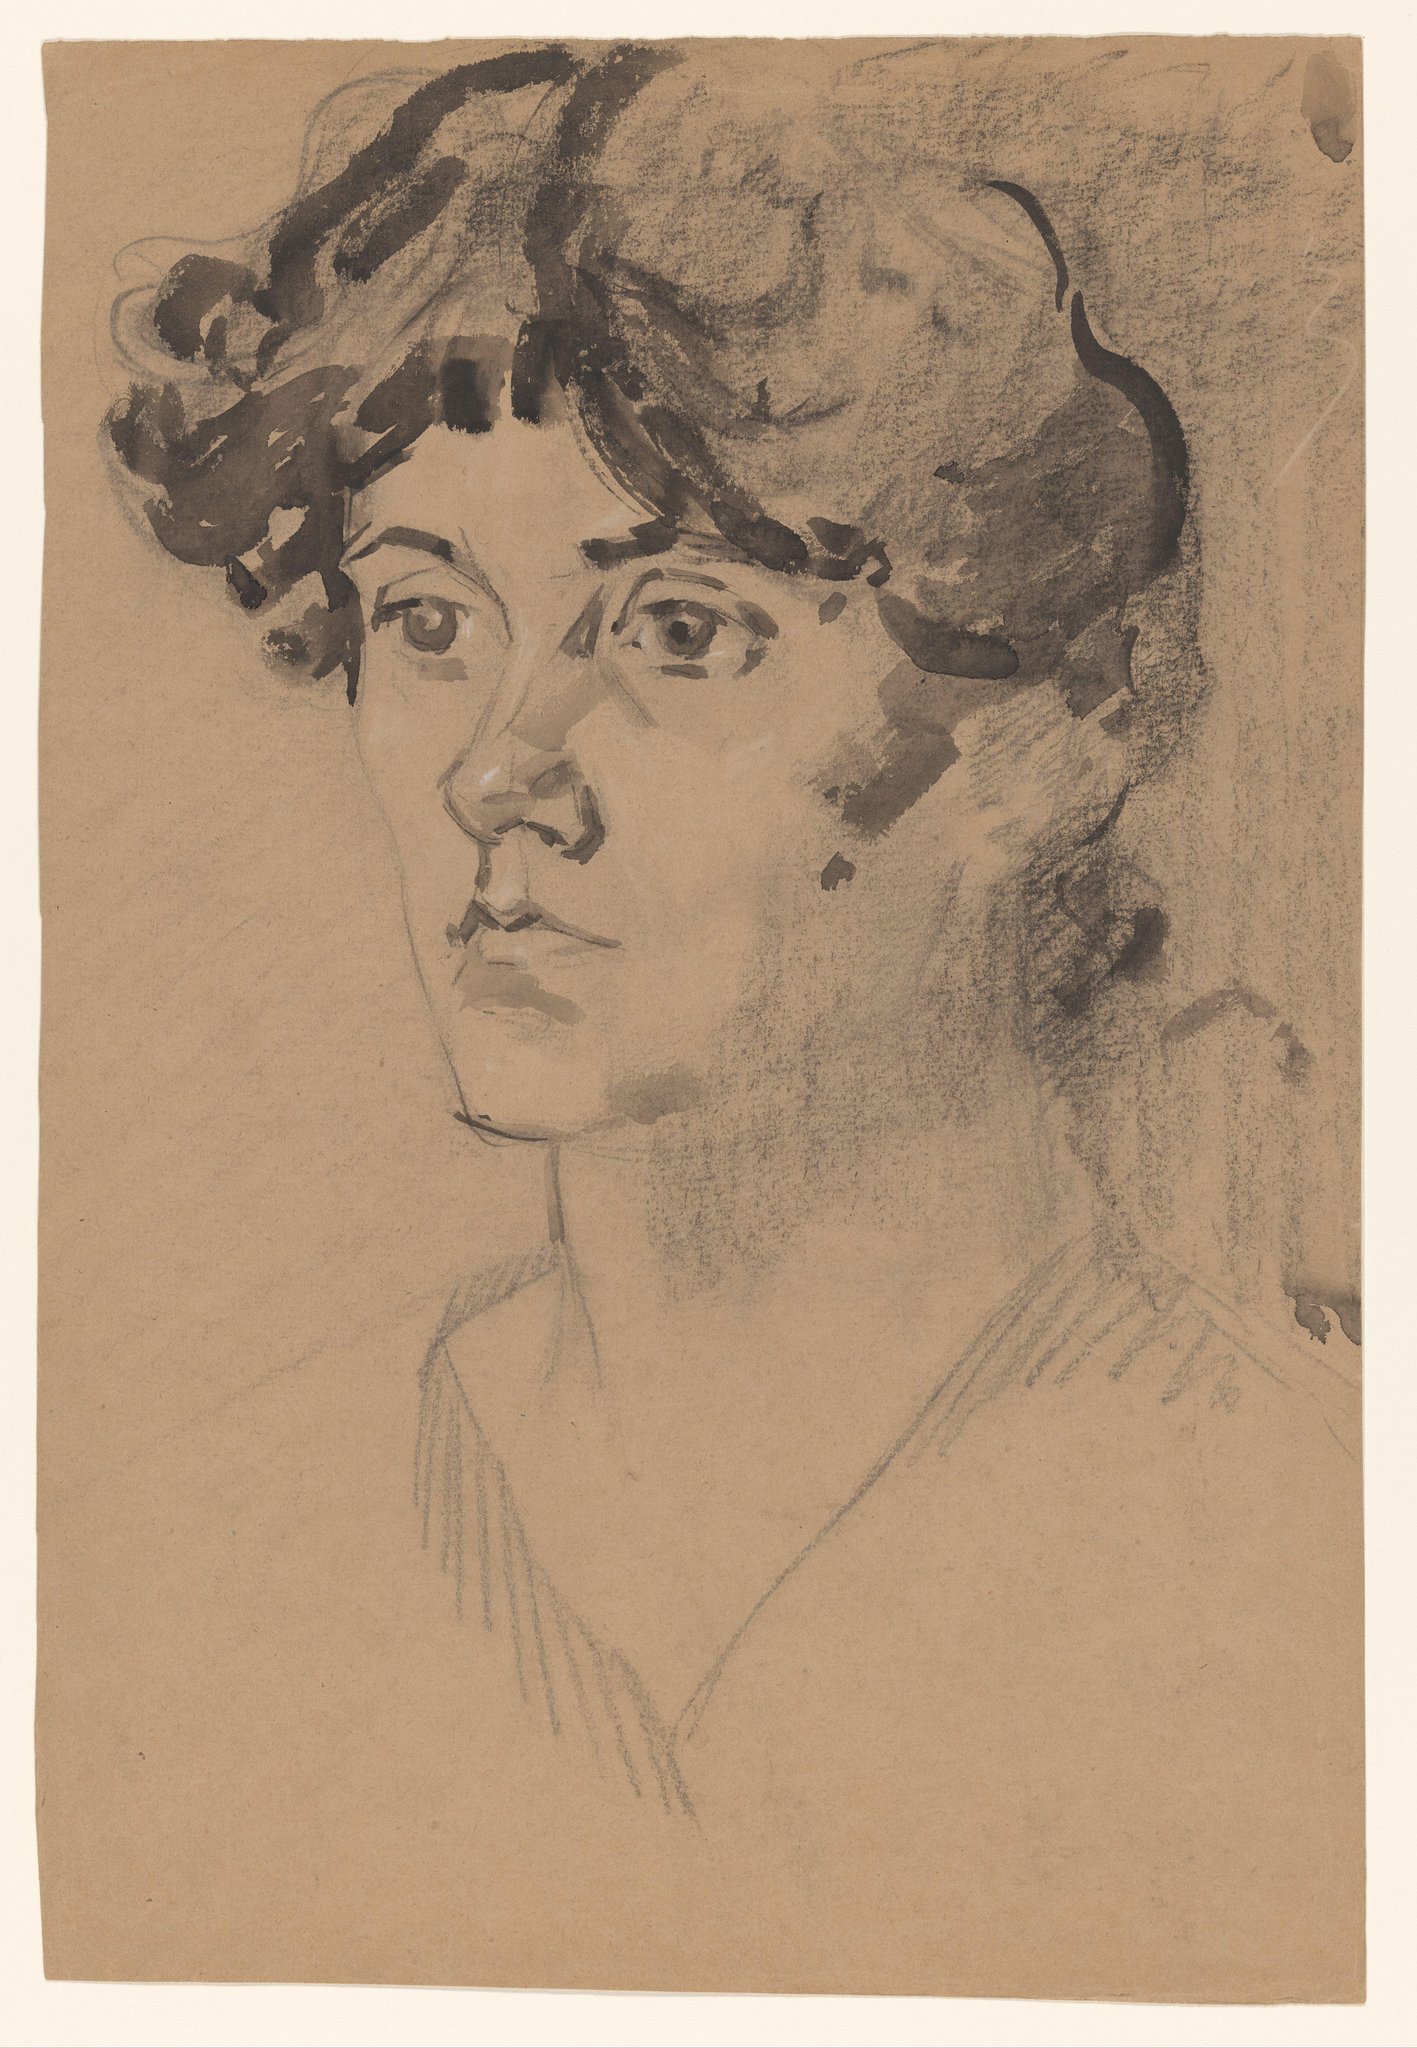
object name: drawing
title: Portret van de vrouw van Wilhelmus Johannes Steenhoff, driekwart naar links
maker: wilhelmus johannes steenhoff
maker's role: draughtsman, print maker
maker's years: 1863-1932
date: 1873-1932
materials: chalk, paper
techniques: brush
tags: historical persons